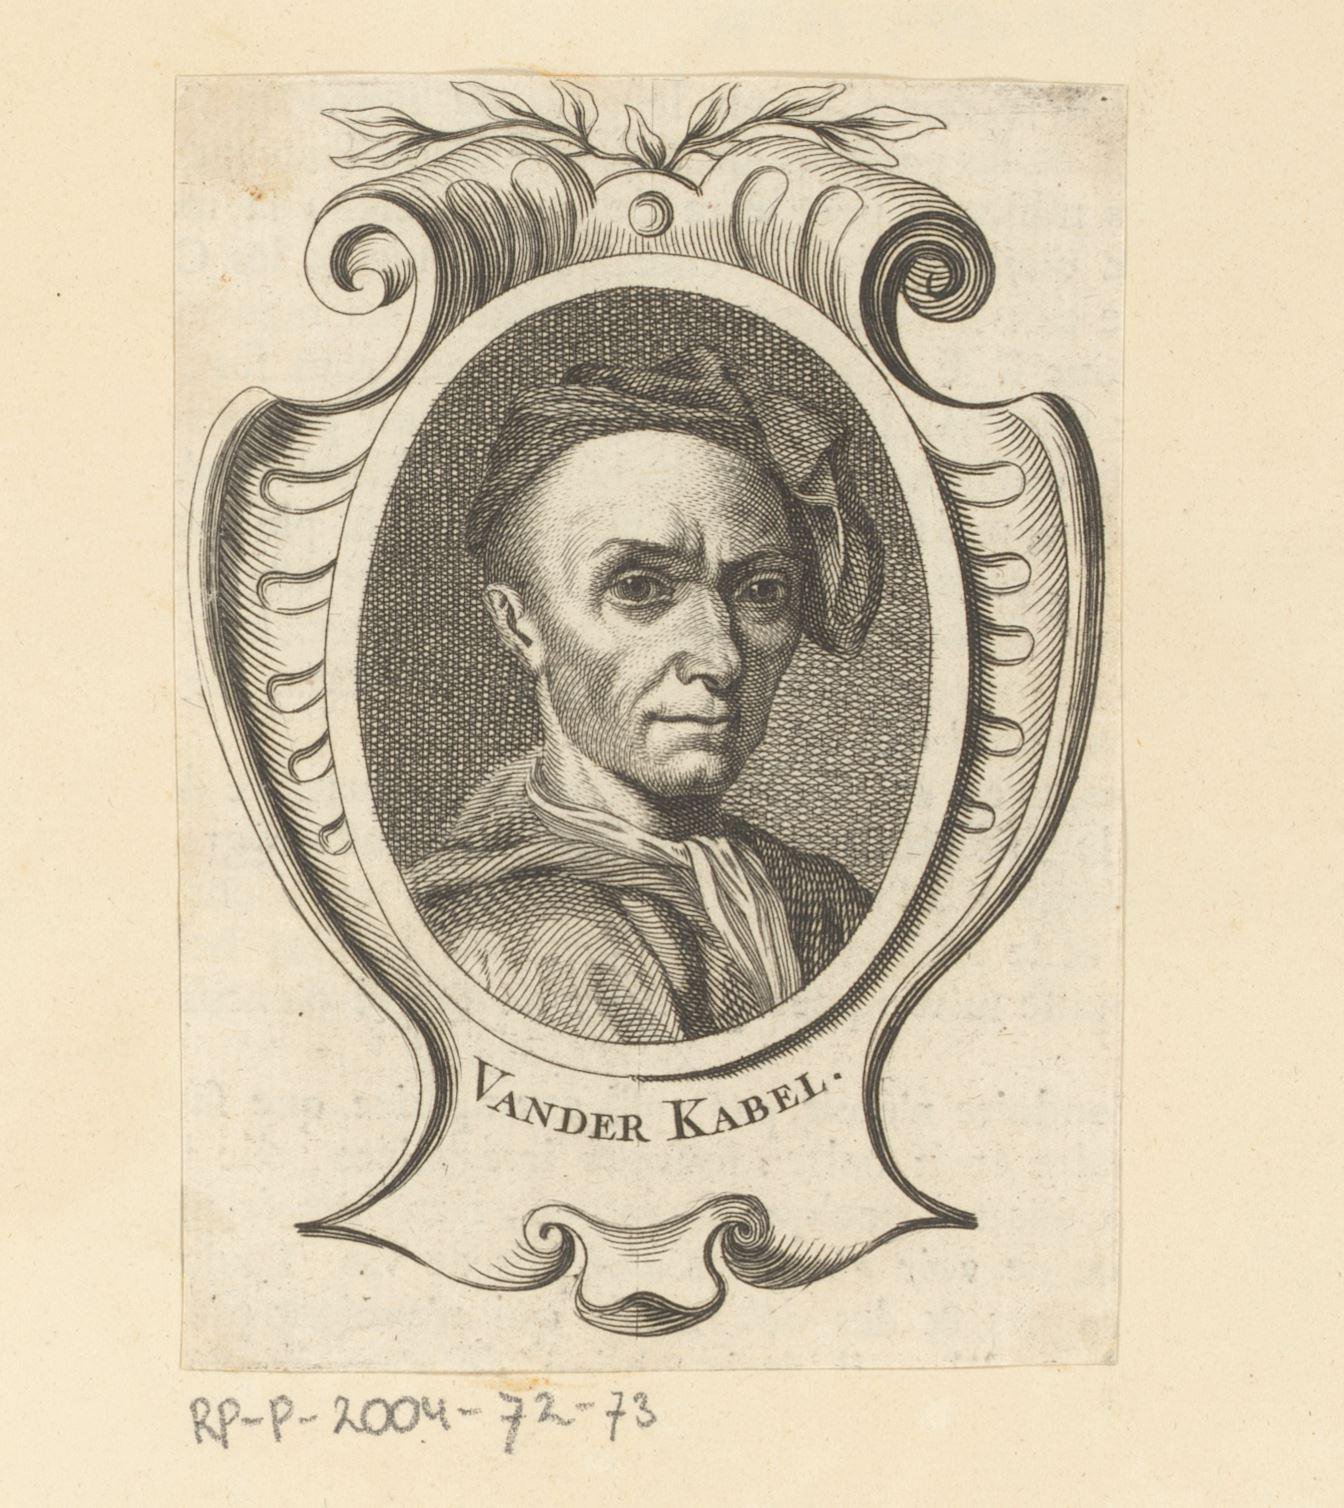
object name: album leaf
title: Portret van Adriaen van der Kabel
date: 1745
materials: paper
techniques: engraving, letterpress printing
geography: paris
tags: lyon, print maker, draughtsman, adriaen van der kabel, historical persons, portrait, self-portrait of painter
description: Prent uit: Dézallier d'Argenville, Antoine Joseph. Abrégé de la vie des plus fameux peintres. 4 dln. Parijs: De Bure l'aîné, 1745, dl. 2, p. 95. De samensteller heeft deze prent in het album geplakt als illustratie bij: Pilkington, Matthew en Johann Heinrich Füssli. A dictionary of painters, from the revival of the art to the present period. 4 dln. Londen: John Crowder, 1805, dl. 1, p. 94.